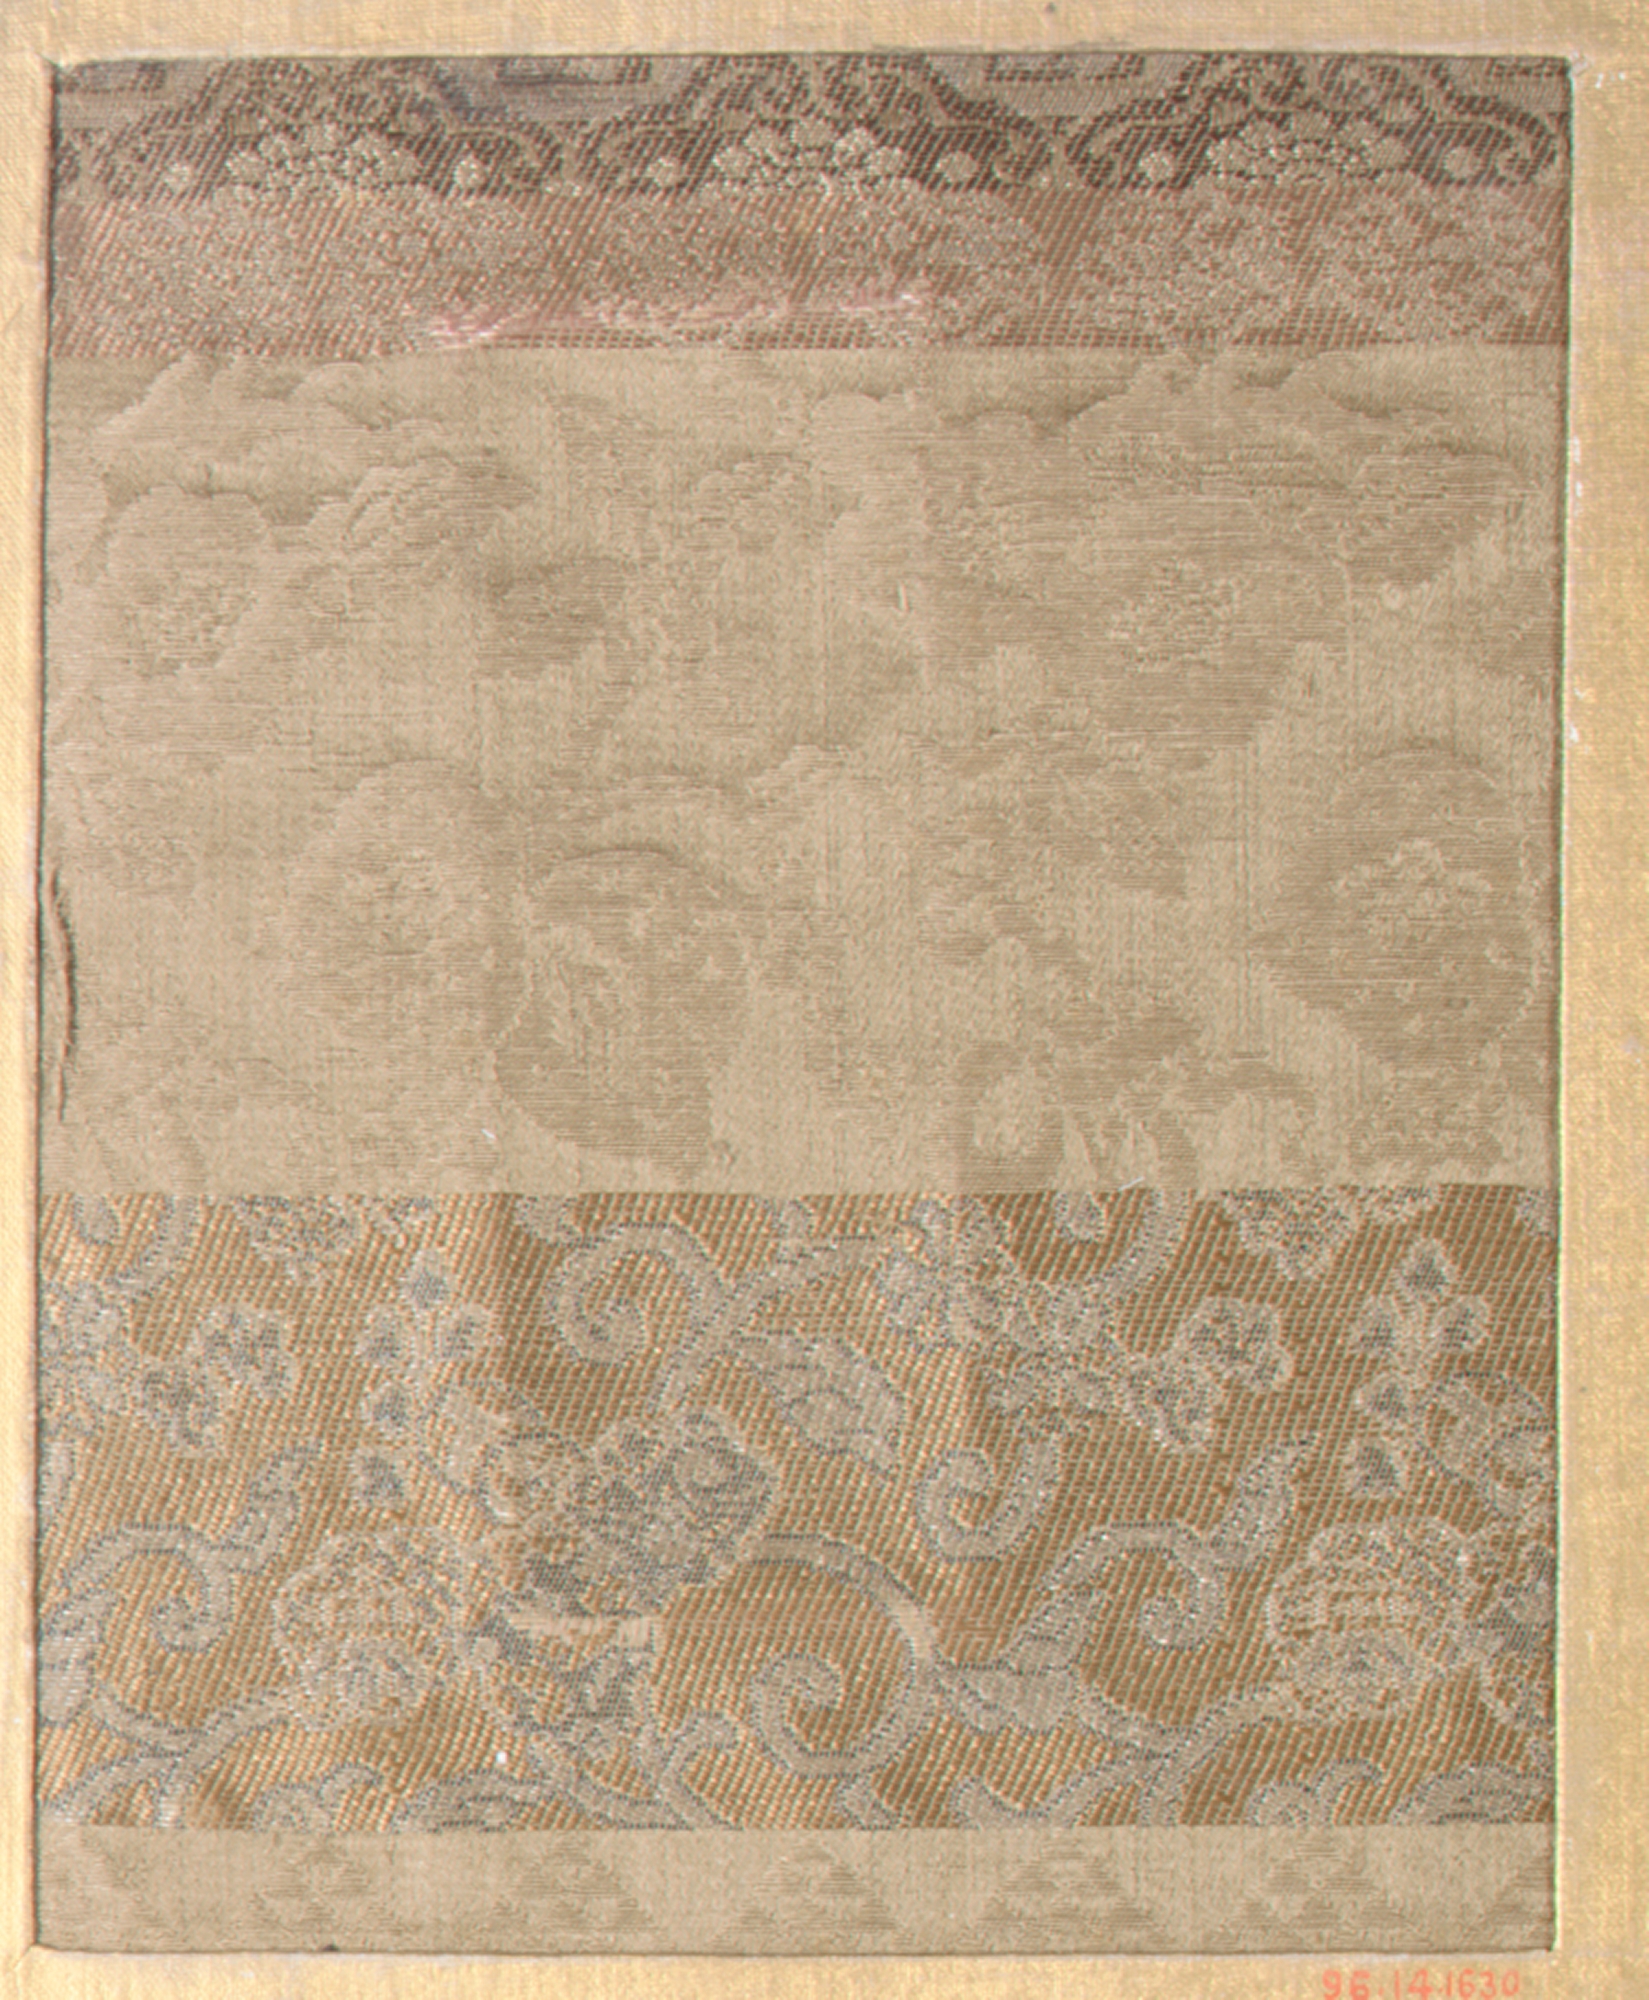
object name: piece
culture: japanese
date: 1701-1900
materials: silk